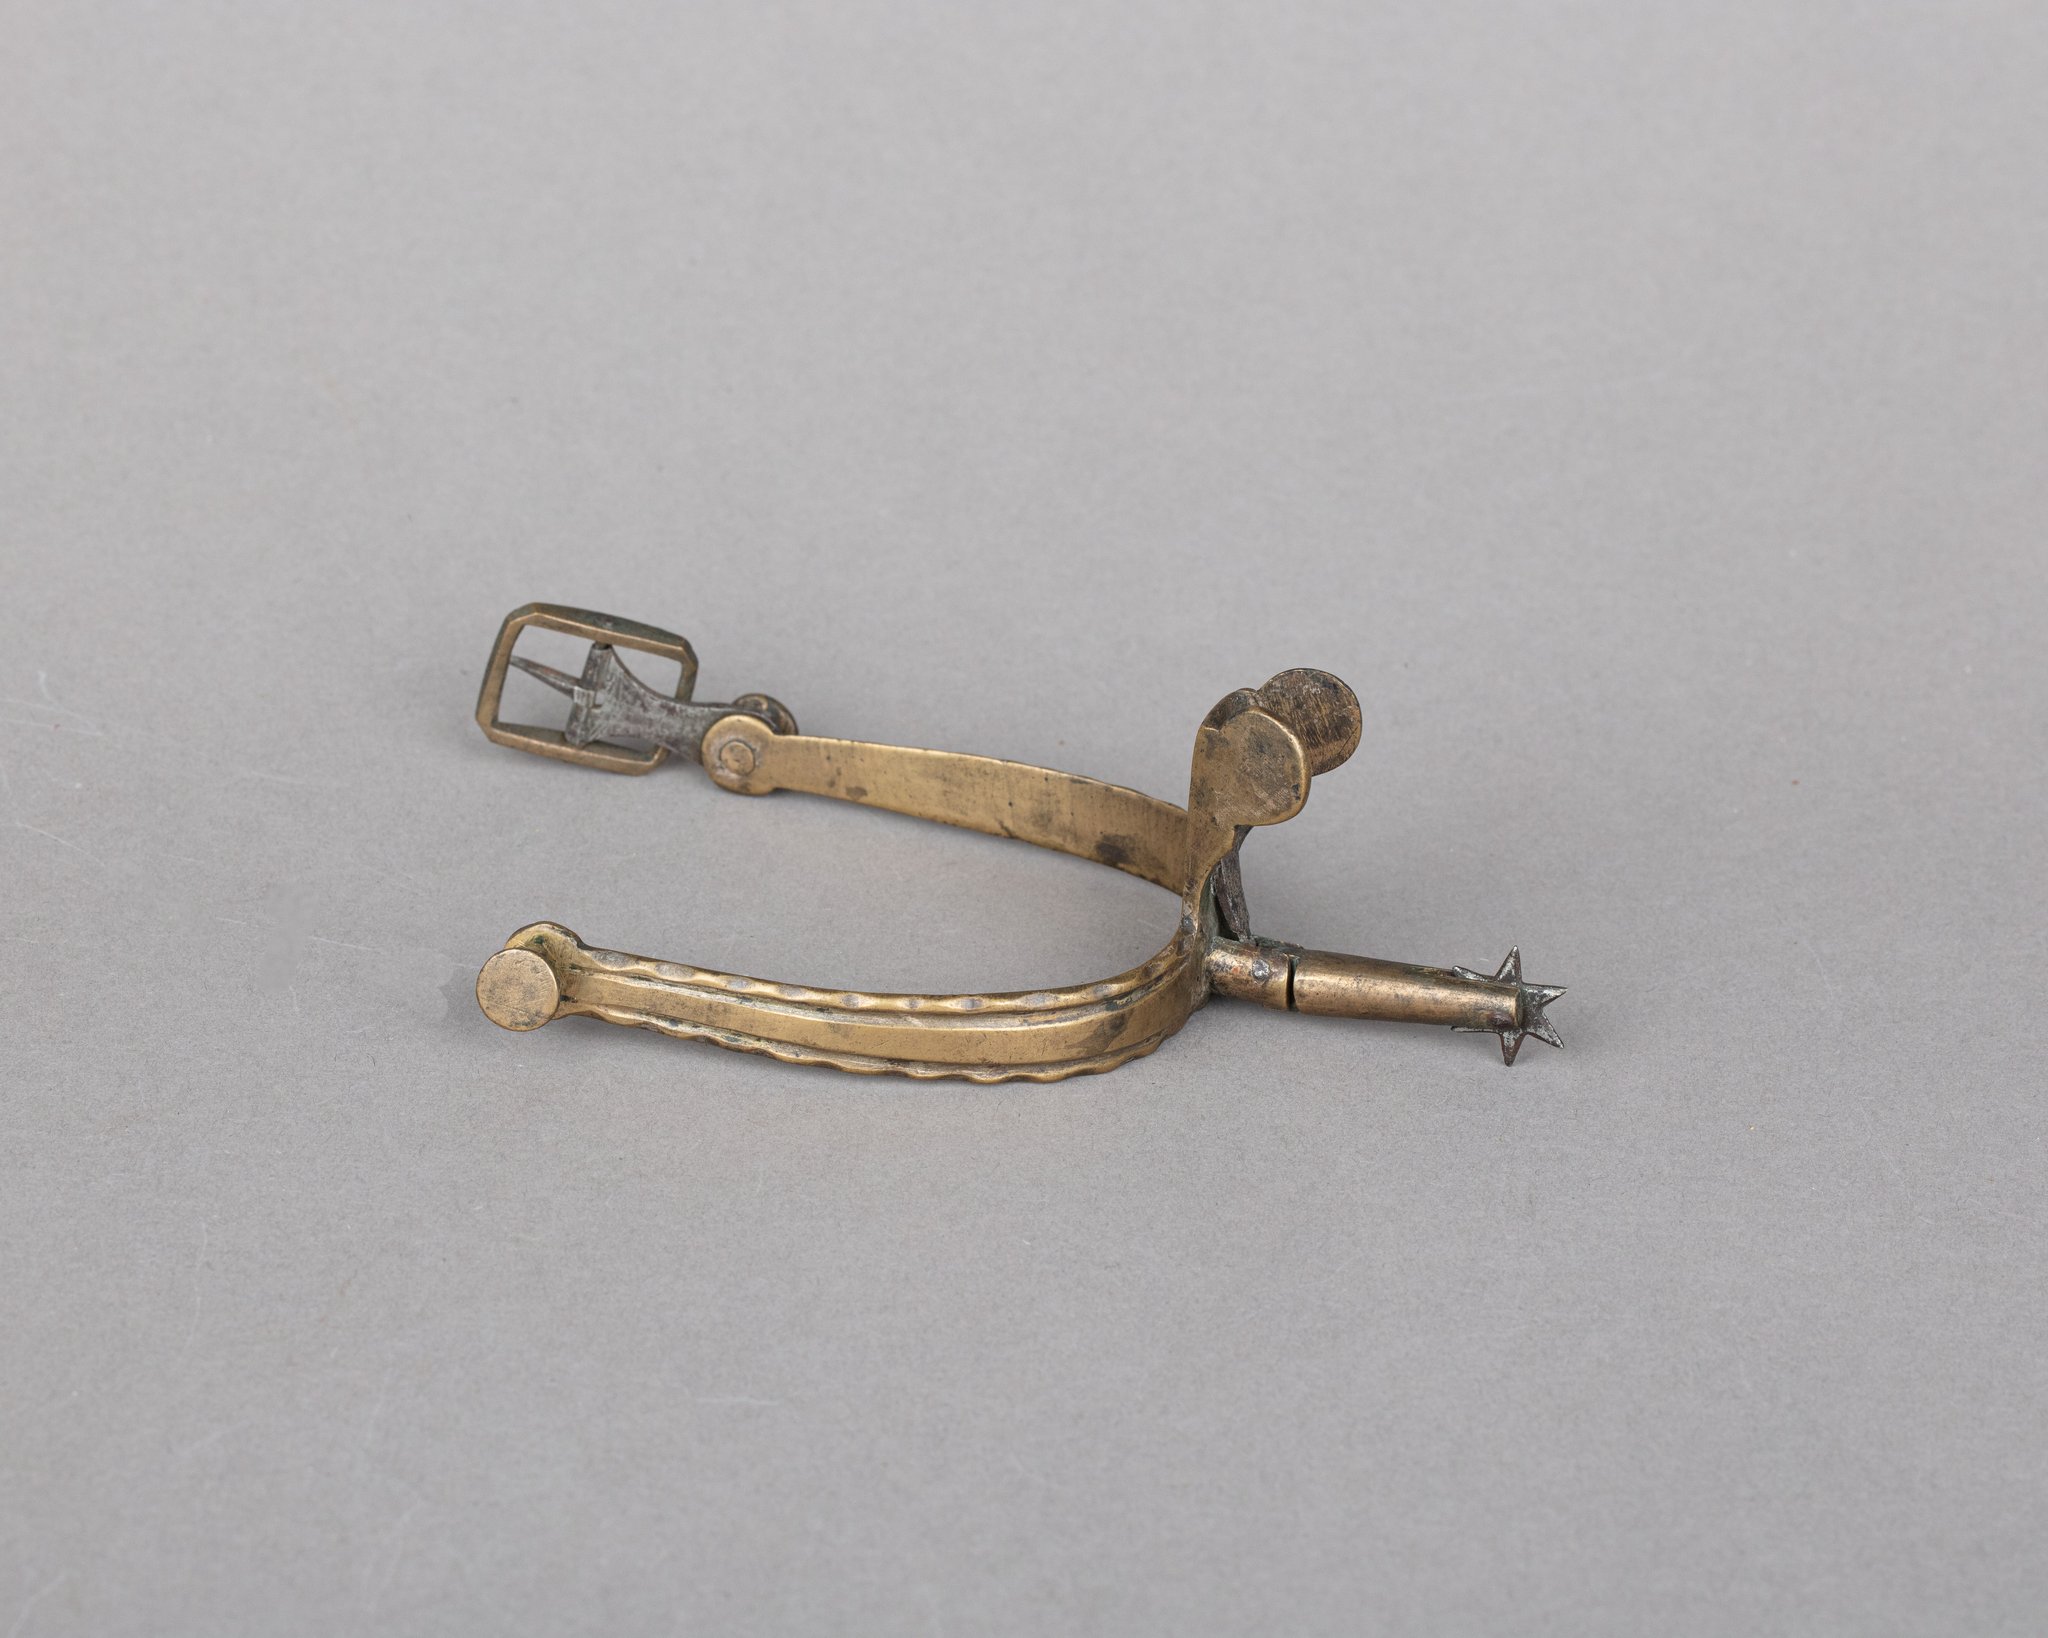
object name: spur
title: Rowel Spur (Right)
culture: french or german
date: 1767-1833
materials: copper alloy, iron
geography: germany